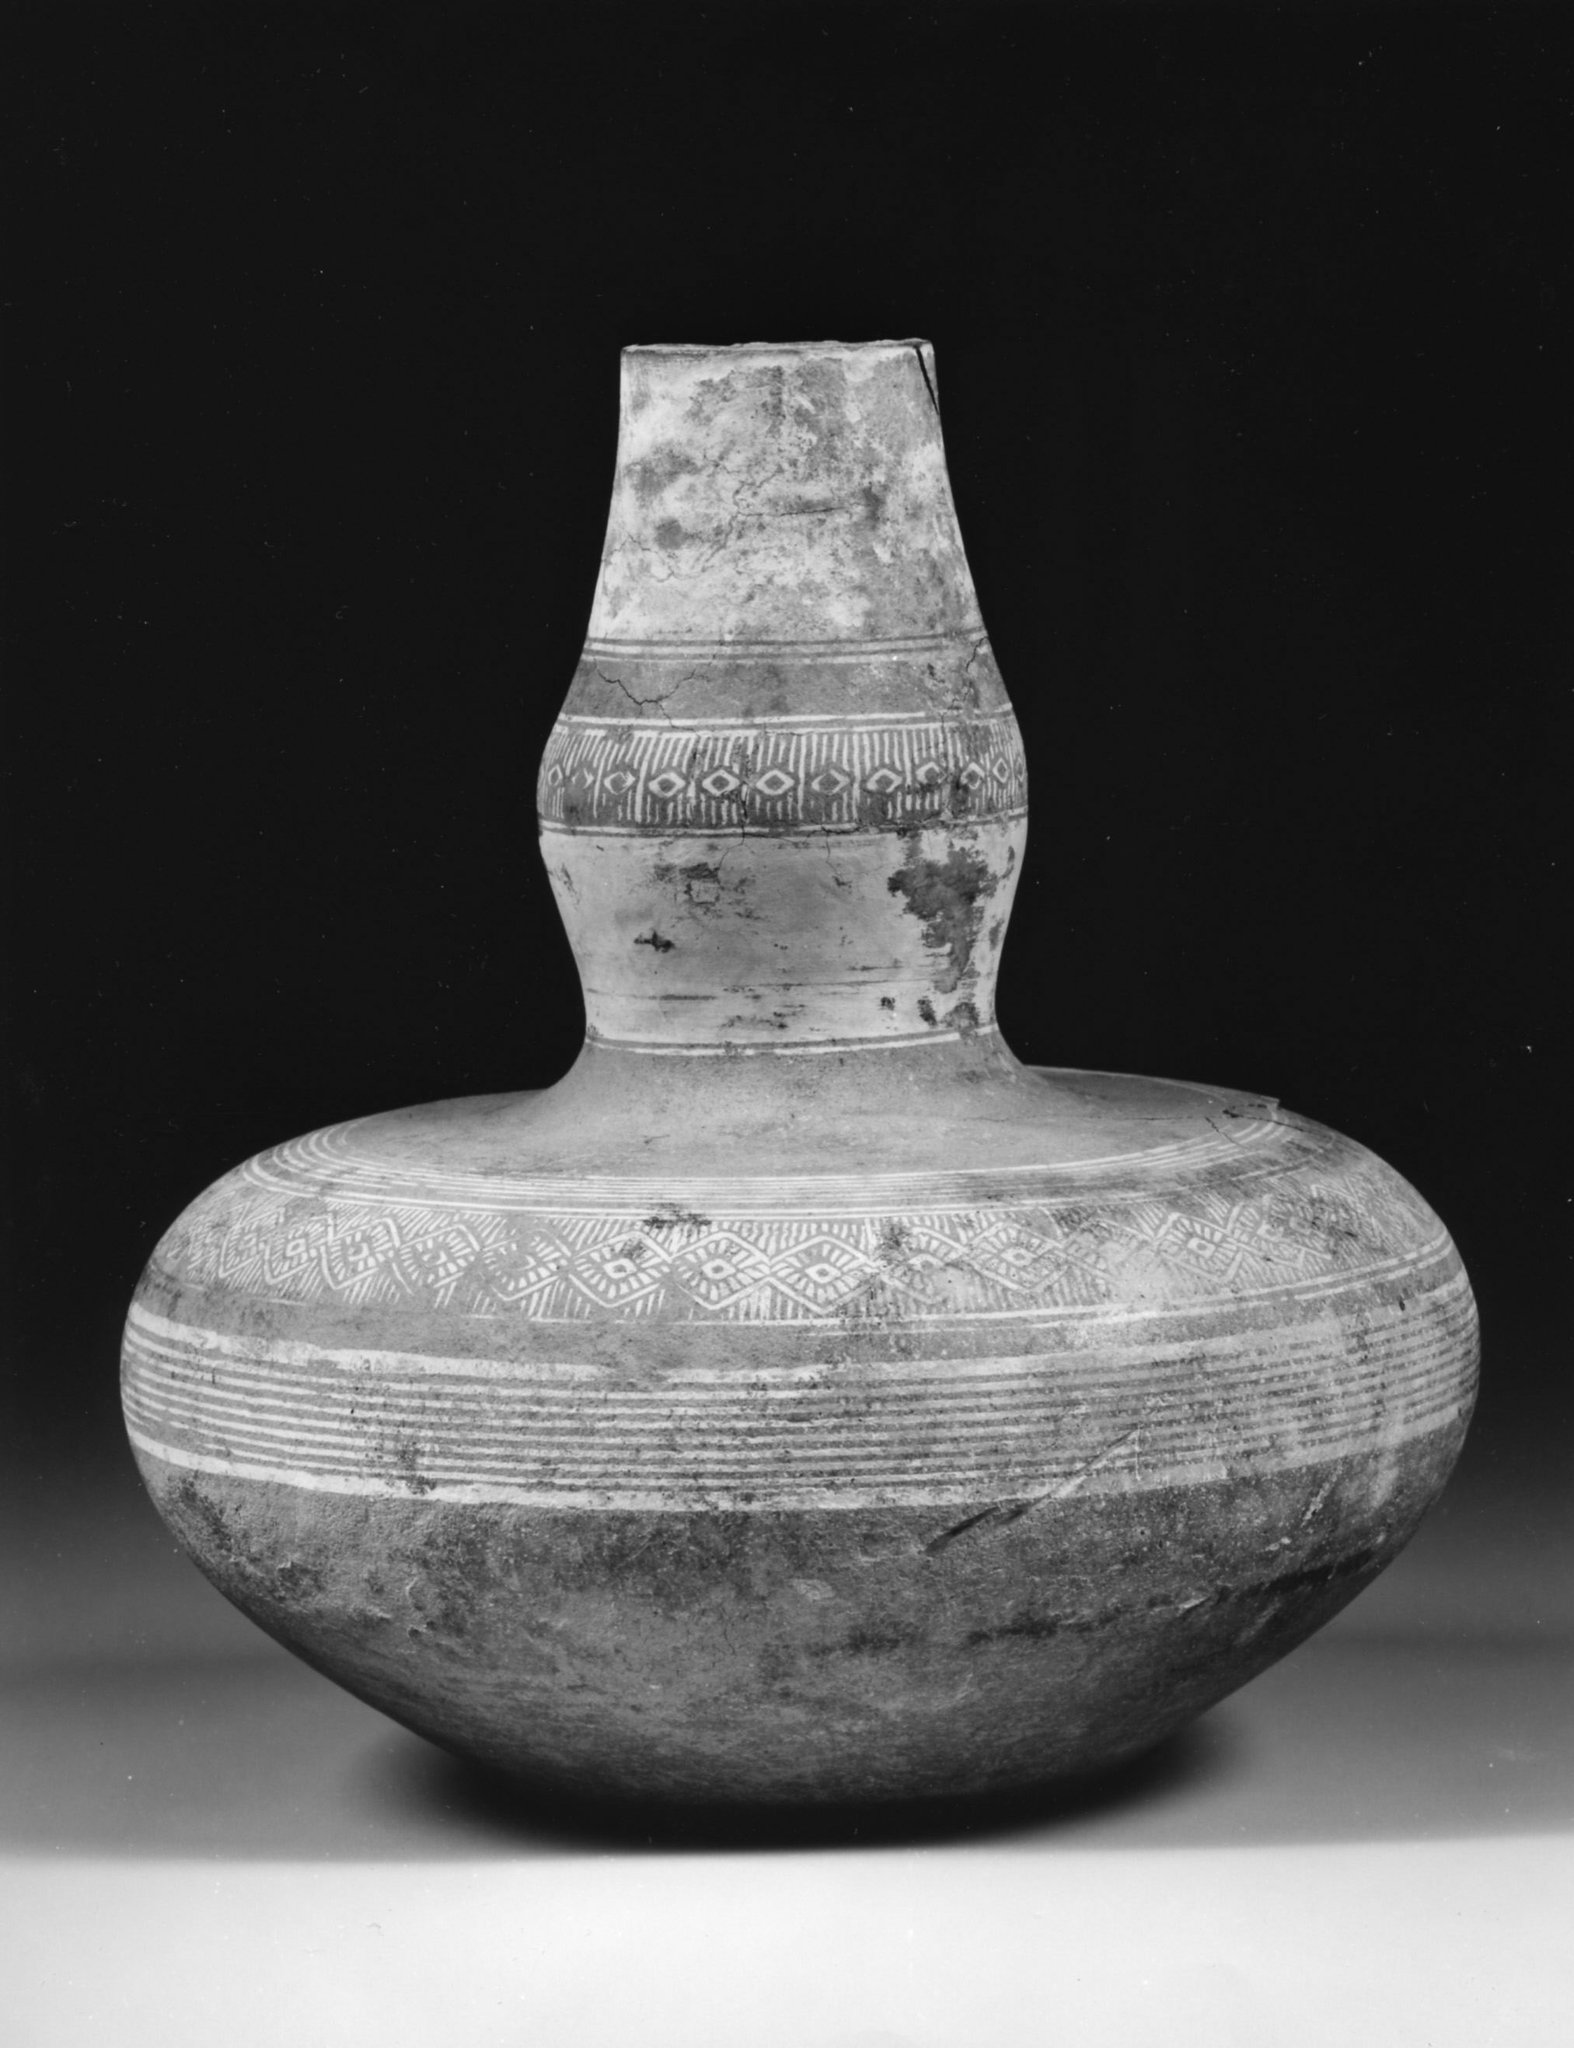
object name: bottle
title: Bottle with Bulbous Neck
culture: thai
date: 1301-1400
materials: terracotta